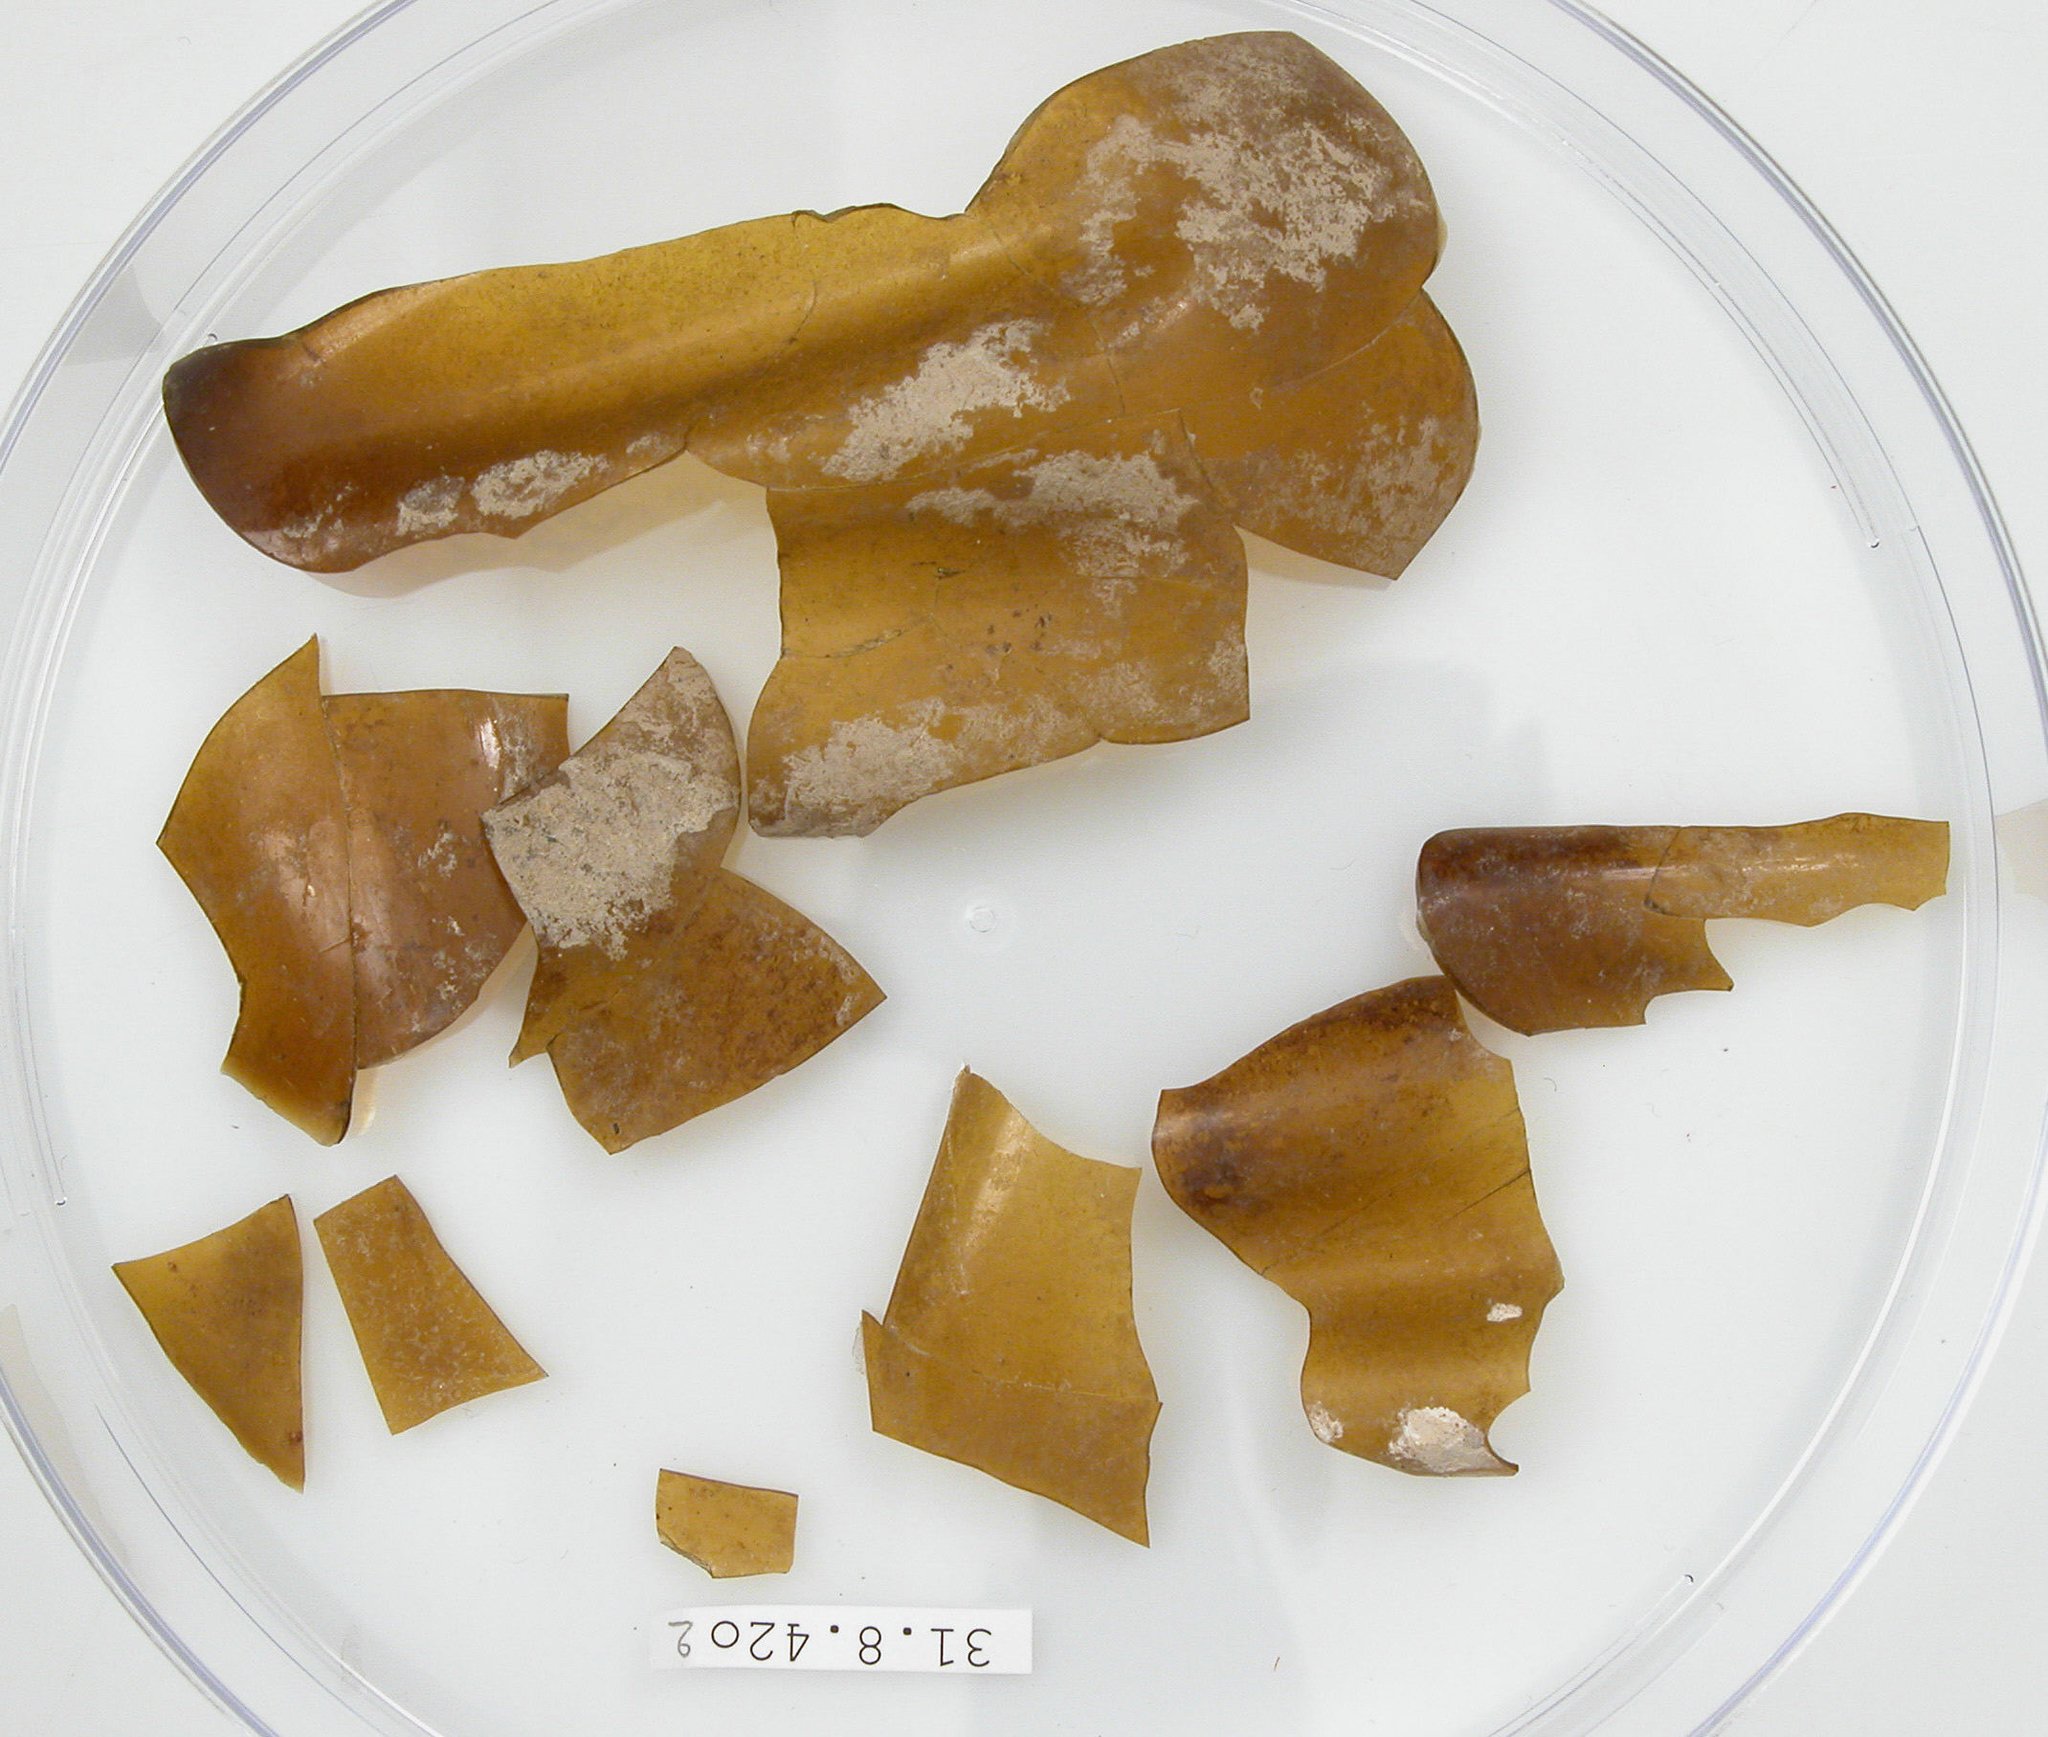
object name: fragment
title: Glass Fragments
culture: coptic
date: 301-400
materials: glass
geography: egypt